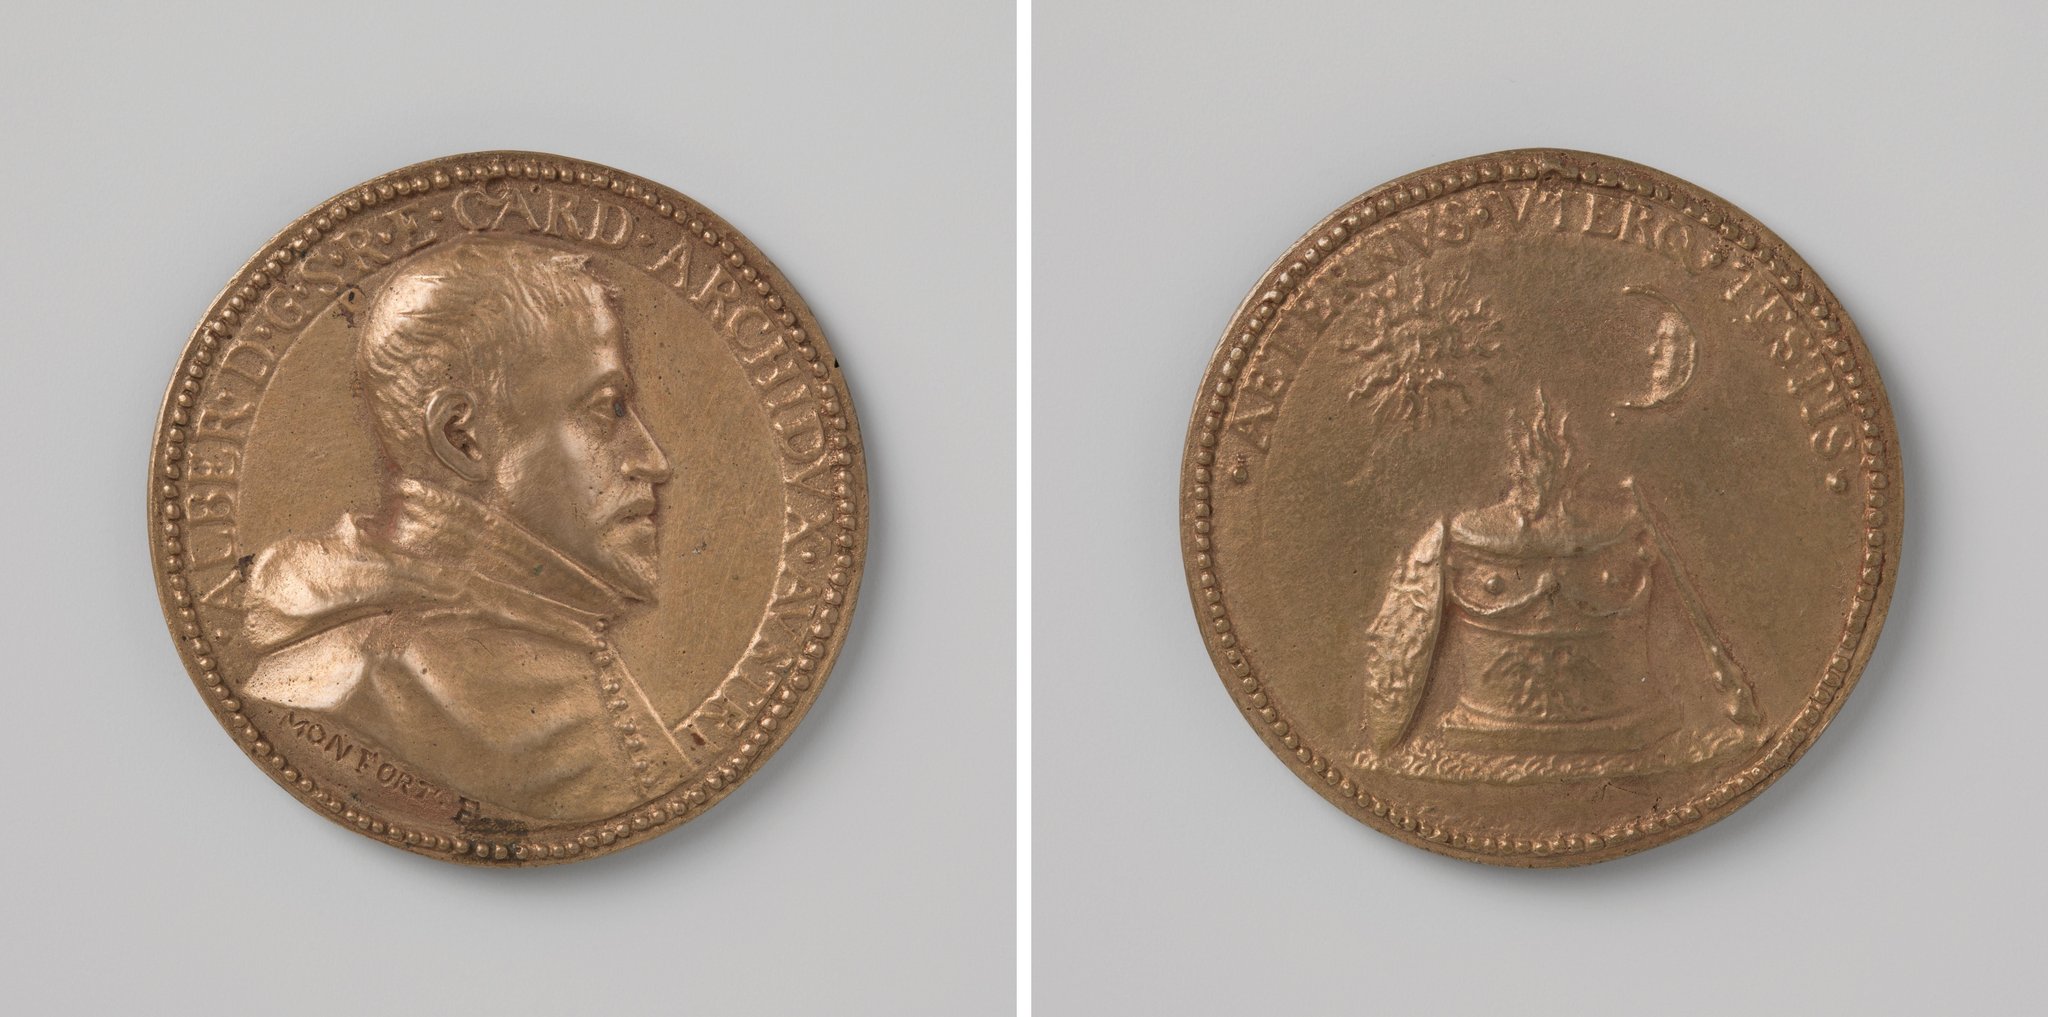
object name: history medal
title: Vredelievende gezindheid van Albertus van Oostenrijk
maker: jean de montfort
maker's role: sculptor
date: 1596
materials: metal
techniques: casting, gilding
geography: brussels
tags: brussels, albrecht aartshertog van oostenrijk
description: Metalen penning. Voorzijde: borststuk man. Keerzijde: knots en schild tegen altaar met vuur.